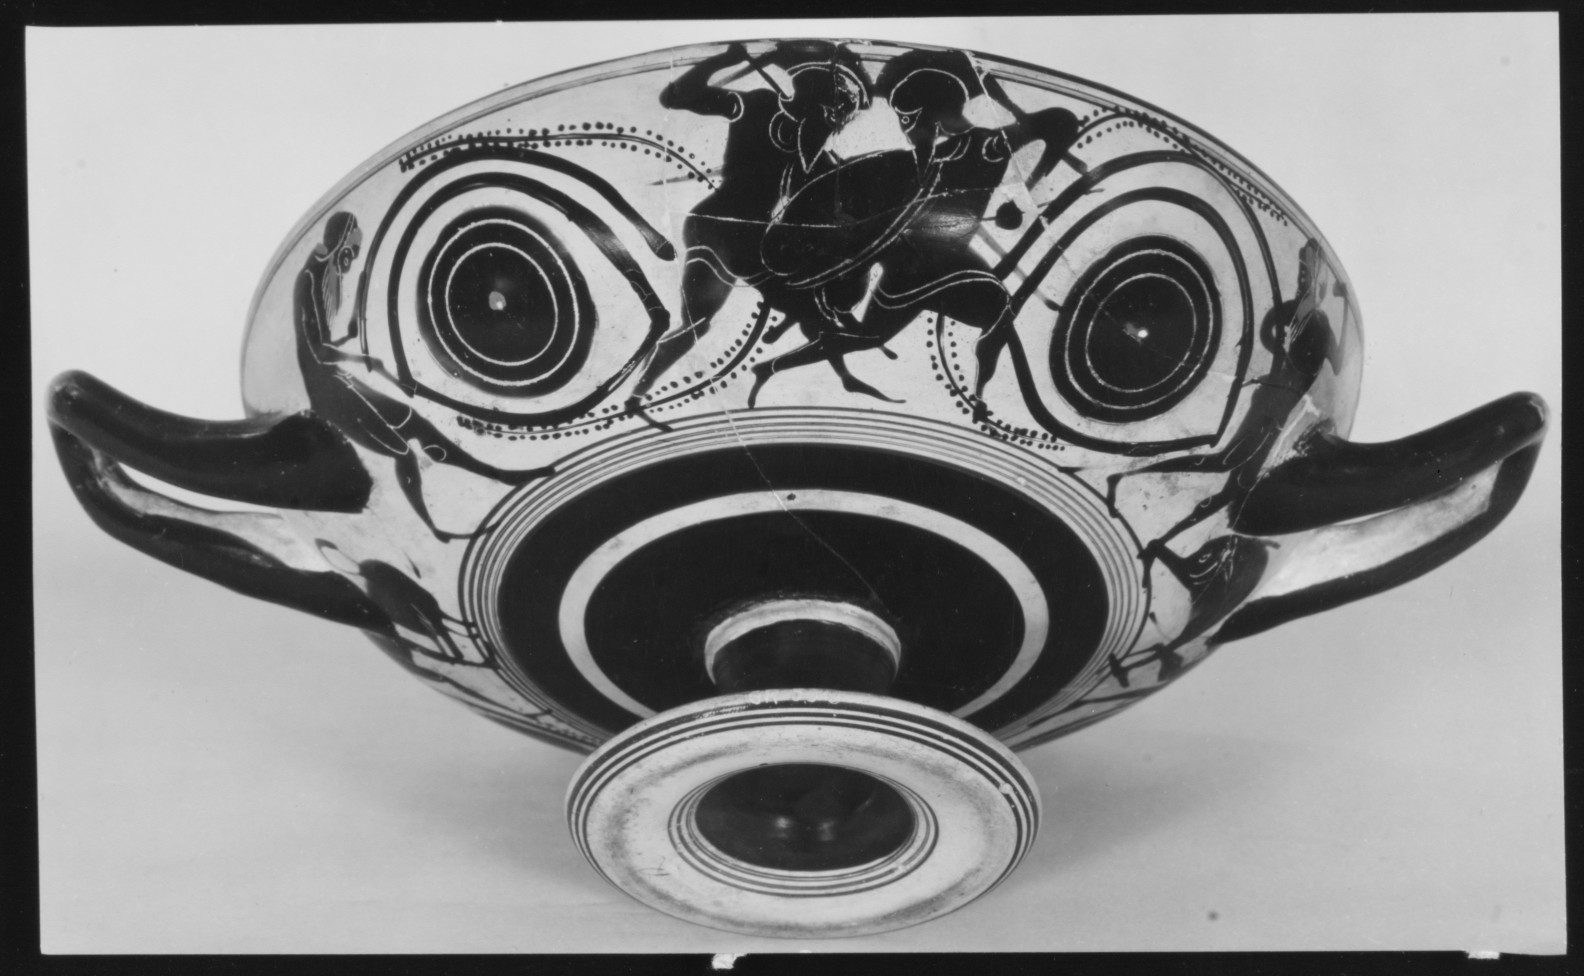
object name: kylix, eye cup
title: Kylix, eye-cup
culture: greek, attic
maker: essen group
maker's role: artist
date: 525-501 BCE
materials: terracotta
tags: eyes,male nudes,satyrs,dolphins